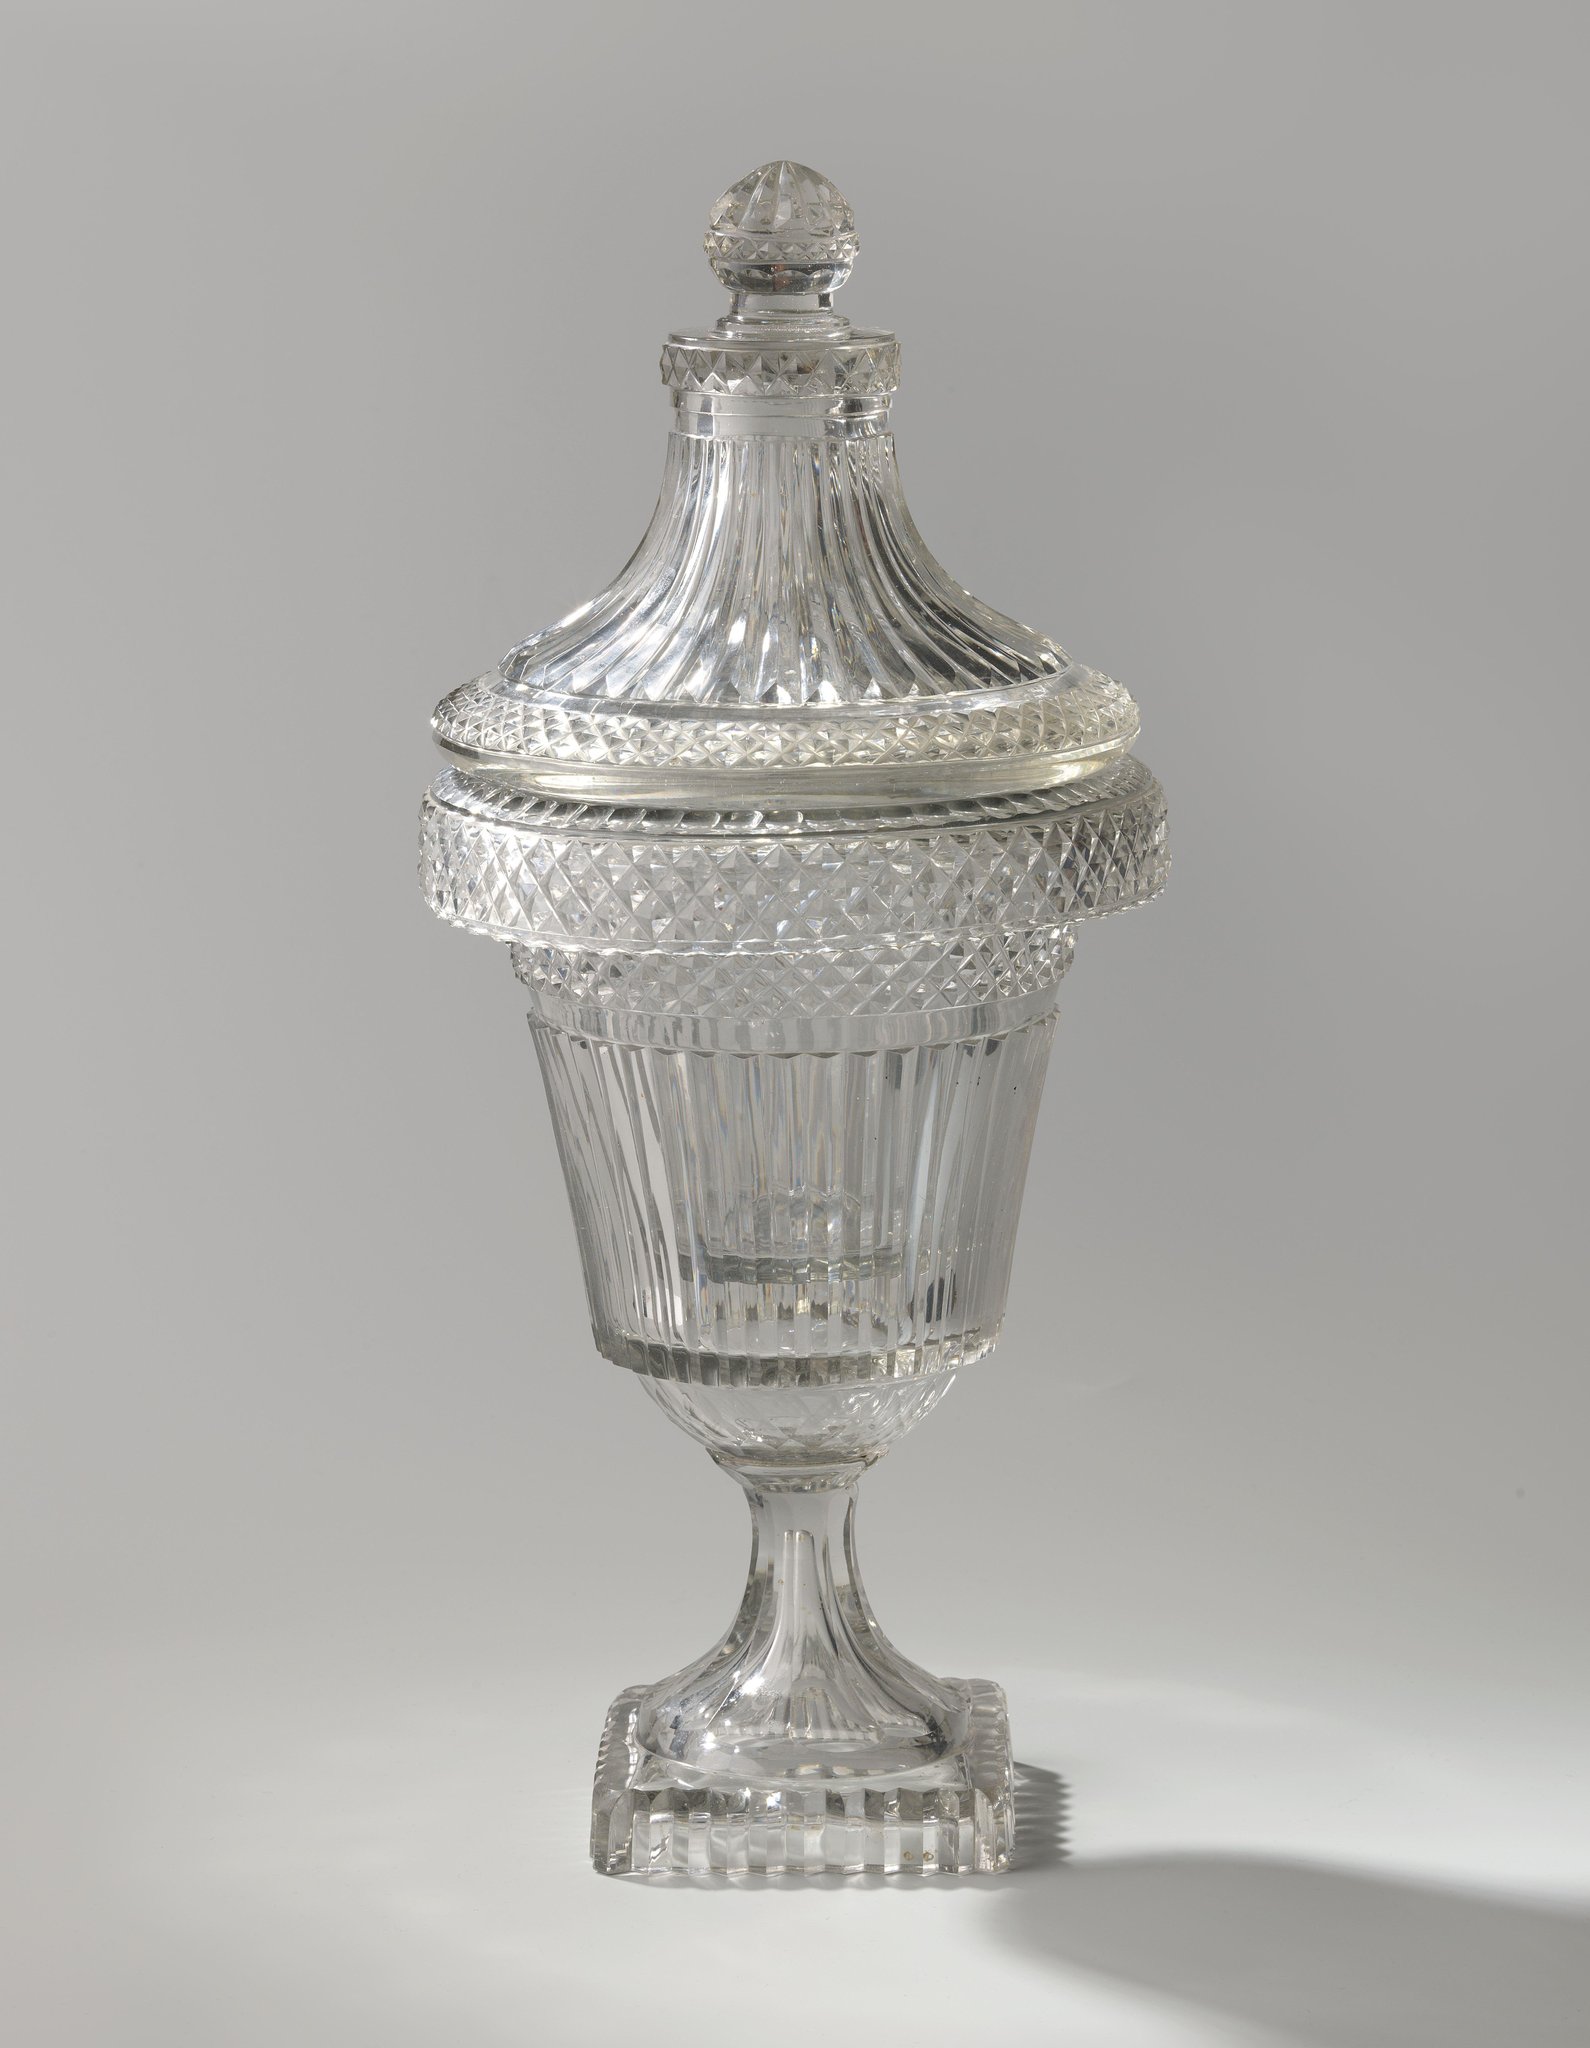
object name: coupe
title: Het deksel van een koelvaas op voet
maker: Anonymous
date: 1820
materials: crystal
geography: ireland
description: Kleurloos kristal met diamant -en V-groefslijpsel. Fabricage imperfectie.